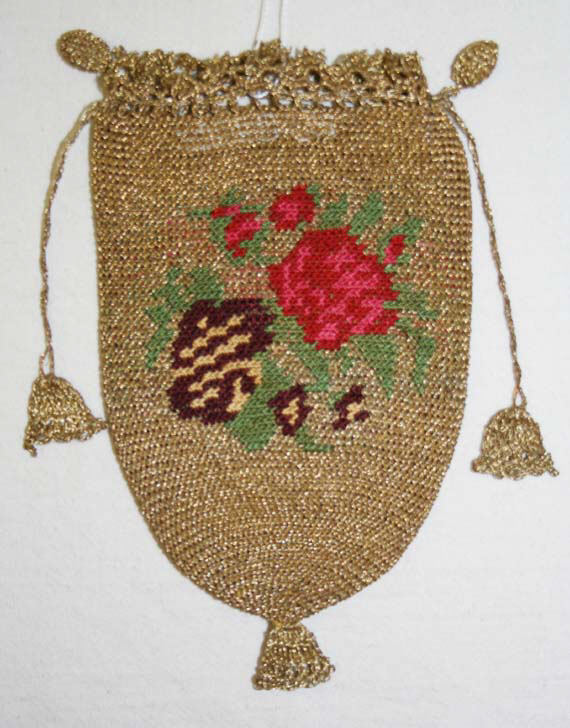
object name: miser's purse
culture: american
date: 1867-1900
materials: metal thread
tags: flowers